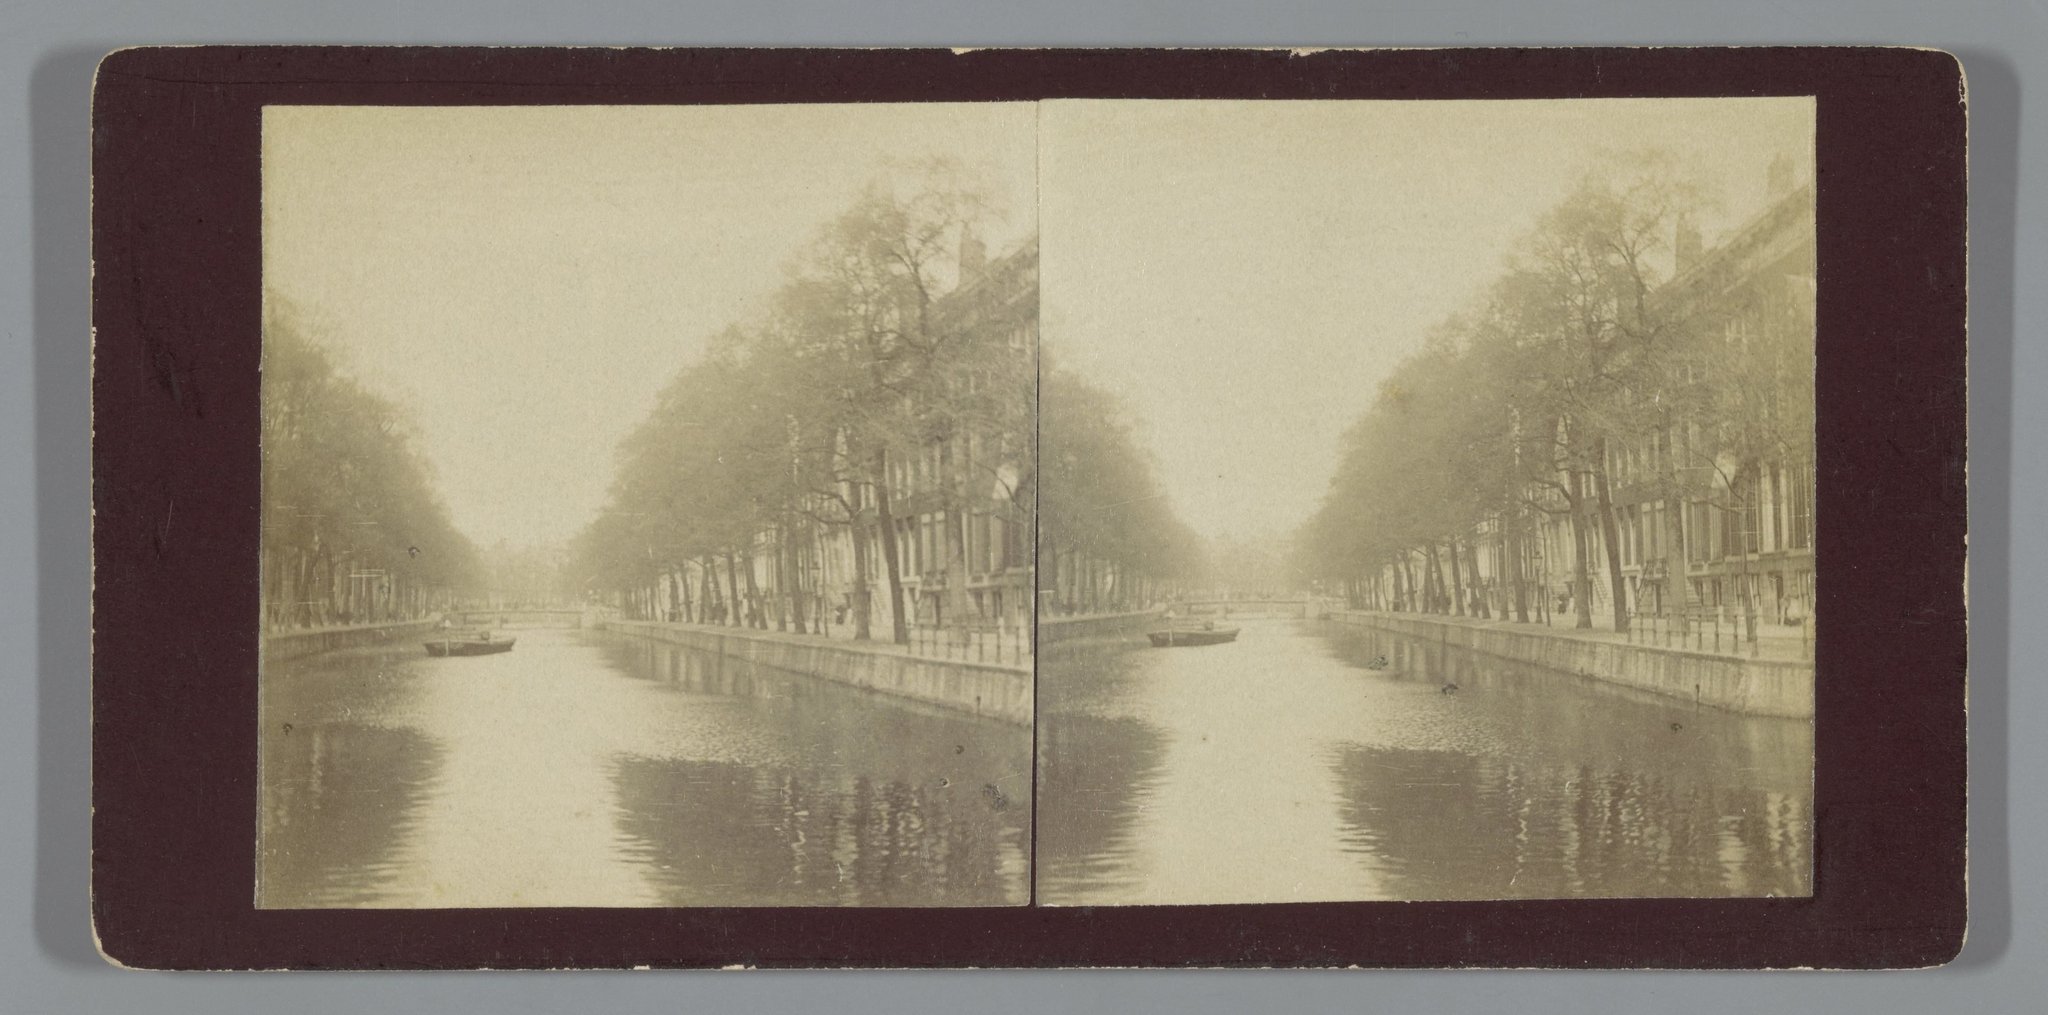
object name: stereograph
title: Gezicht op een gracht in Amsterdam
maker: Anonymous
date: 1868-1890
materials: cardboard, paper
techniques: albumen print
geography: amsterdam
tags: canals, waters (in city), amsterdam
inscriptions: number: ‘52’